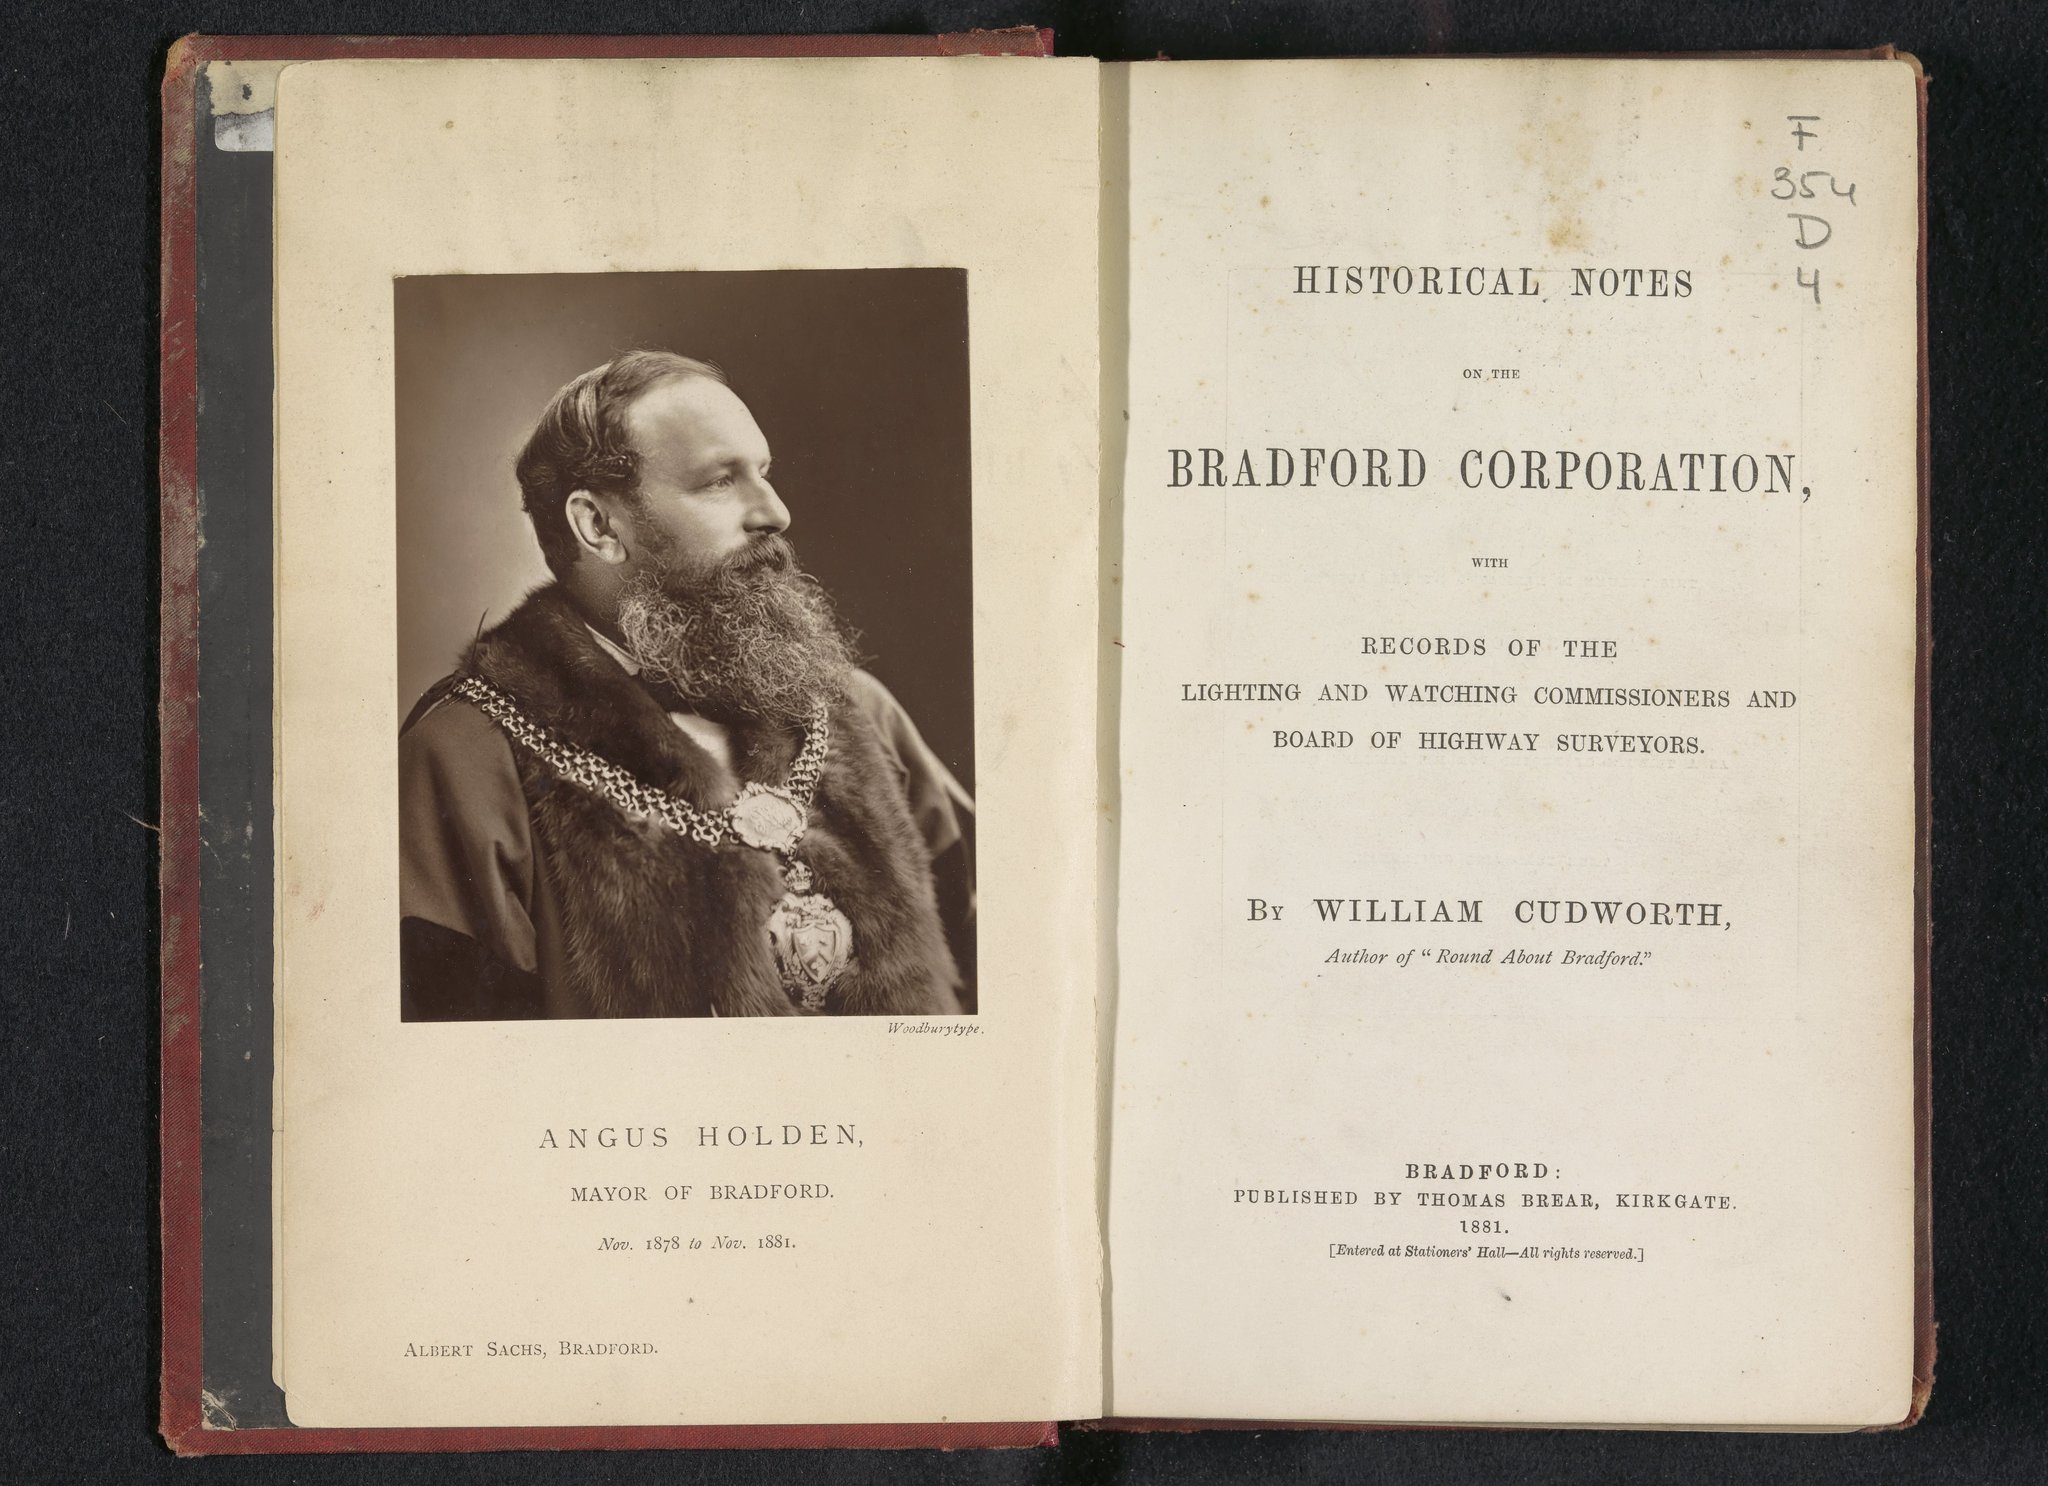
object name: book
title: Historical notes on the Bradford corporation with record of the lighting and watching commissioners and board of highway surveyors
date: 1881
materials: cardboard, linen, paper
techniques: etching, lithograph, printing, woodburytype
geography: bradford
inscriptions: inscription: ‘Boddy's bookshop 165 Linthorpe Road Middlesbrough’